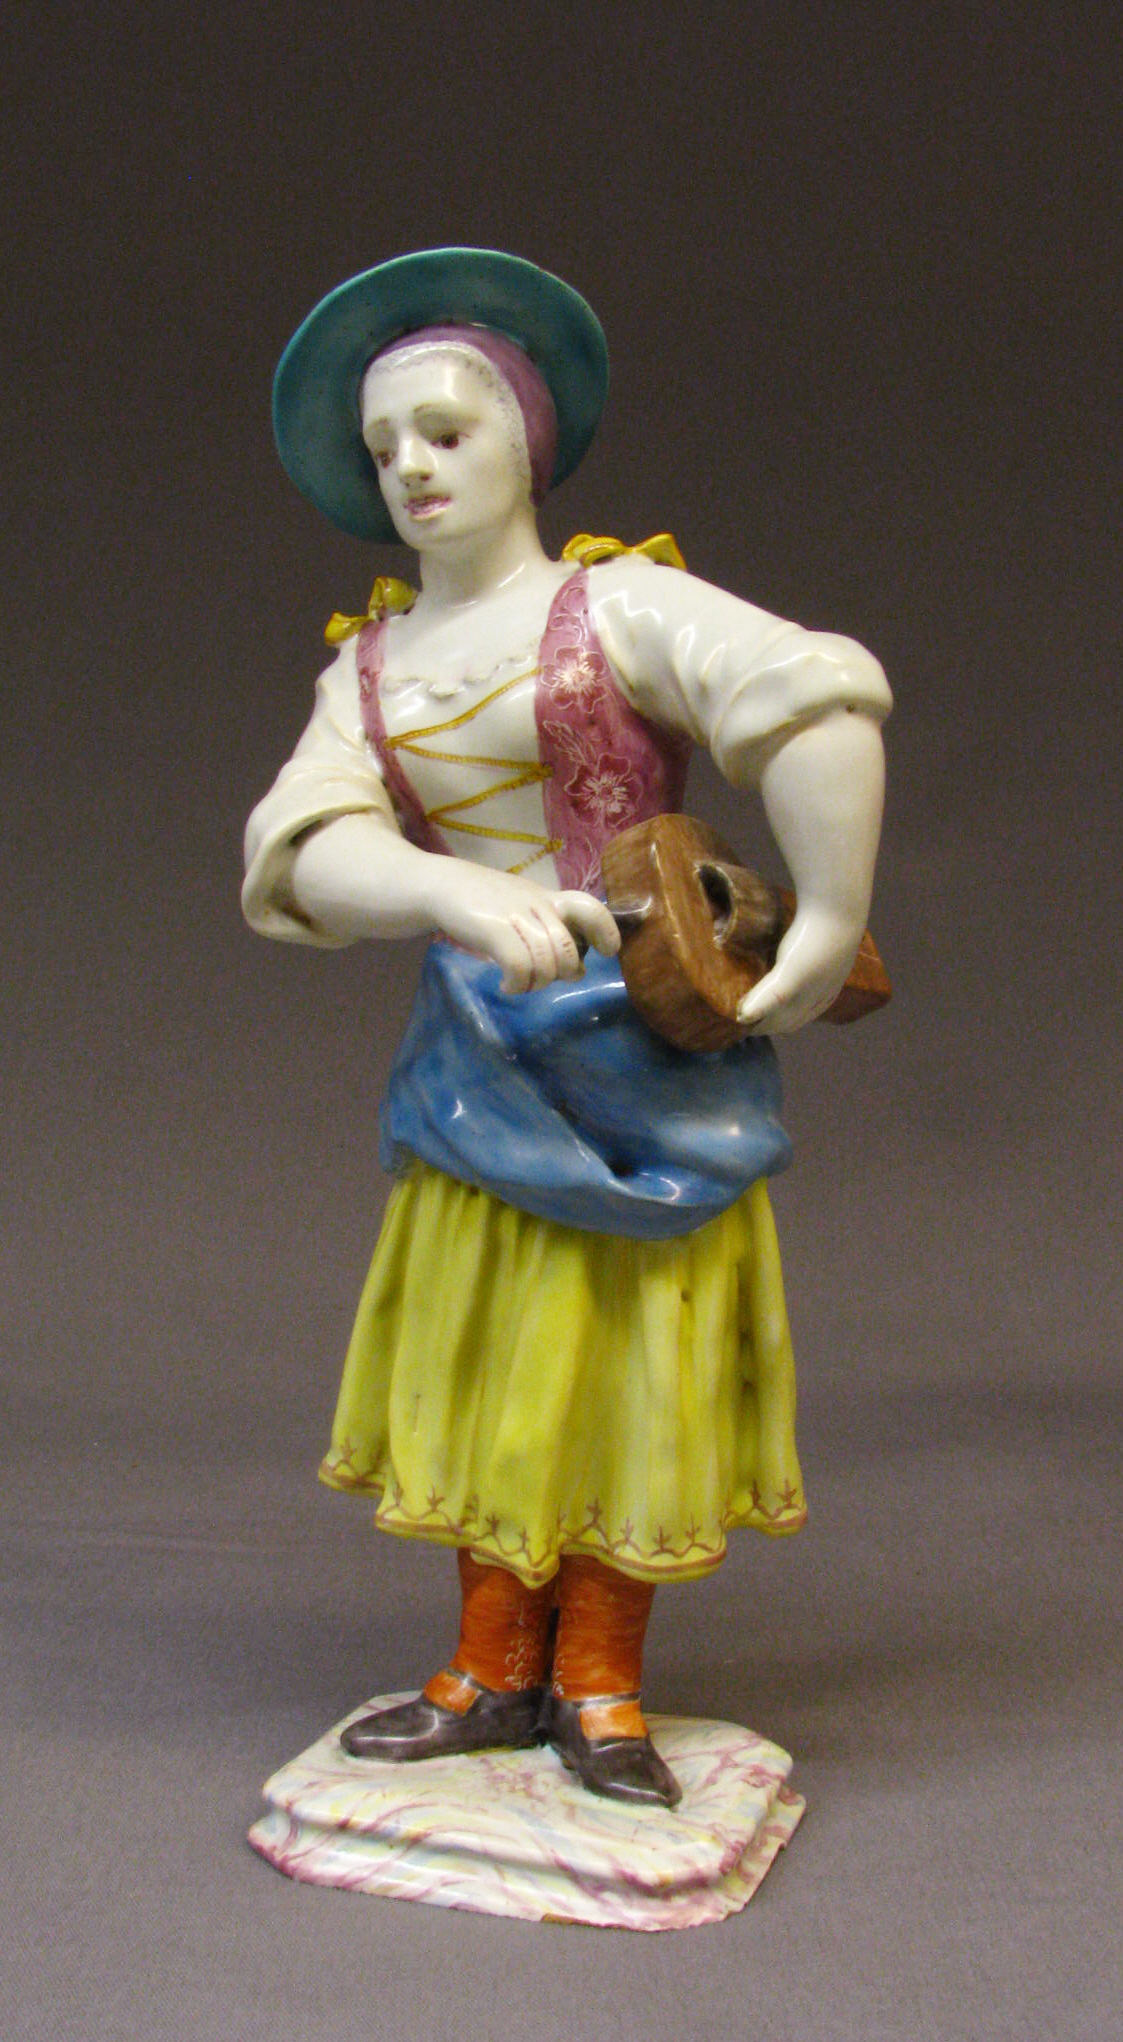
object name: figure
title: Girl cranking a hurdy-gurdy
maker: johannes zeschinger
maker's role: decorator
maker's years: 1723-1823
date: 1746-1753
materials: earthenware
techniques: glazing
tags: musical instruments,girls